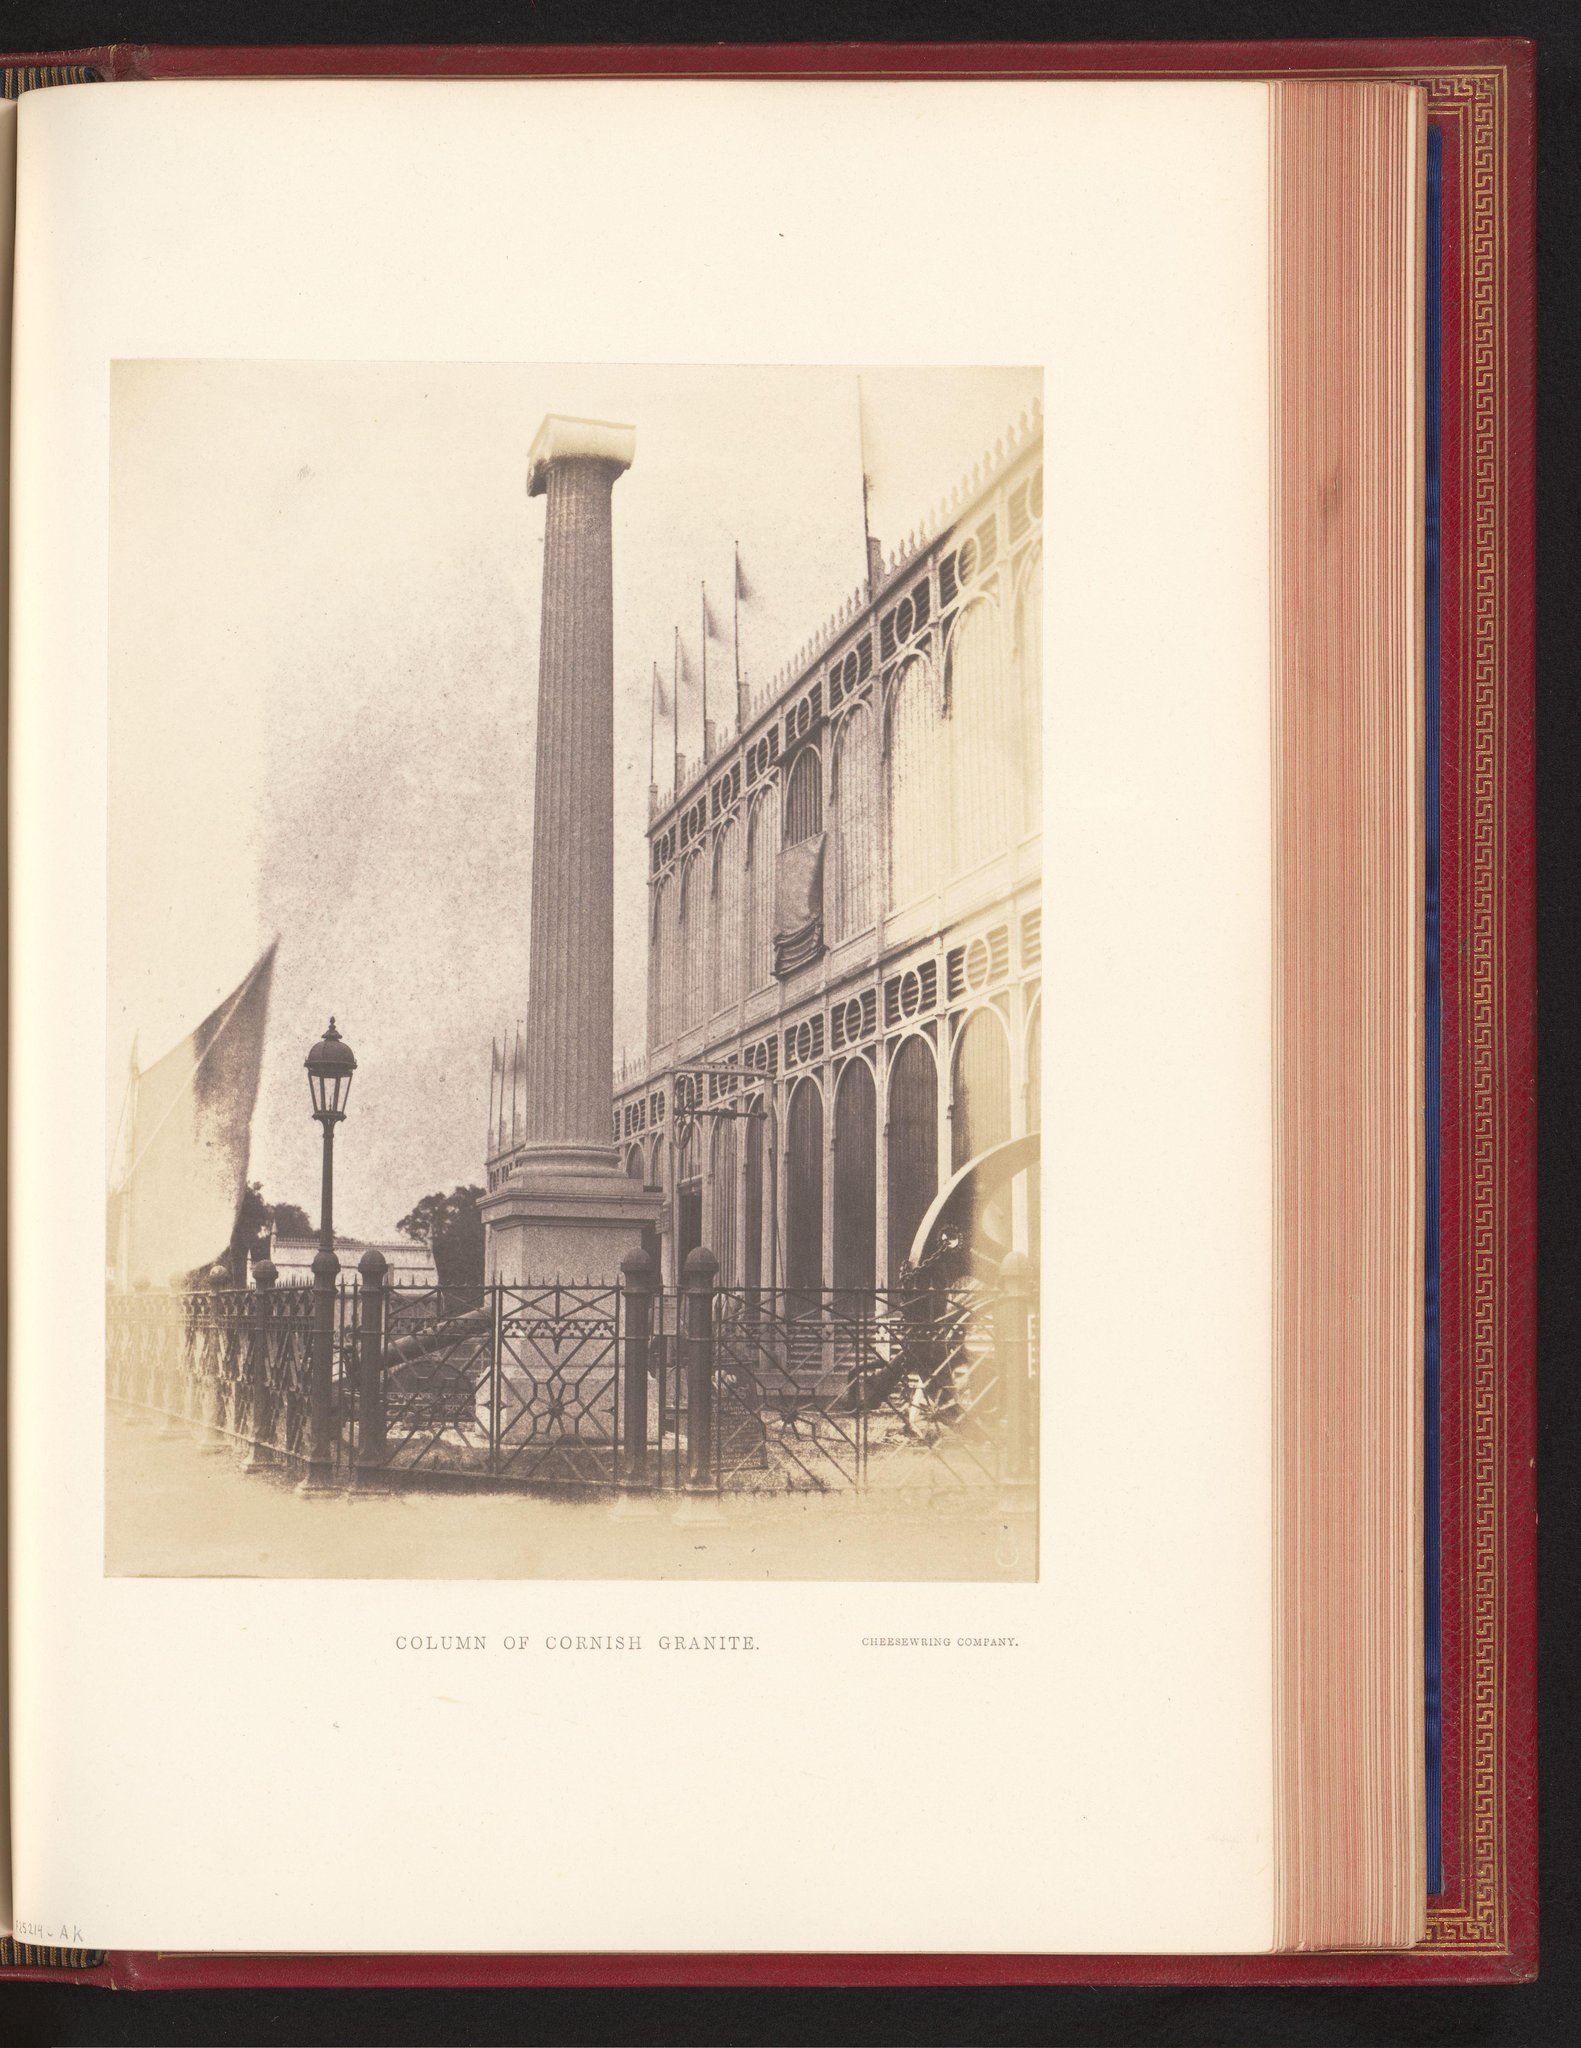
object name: photograph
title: Column of Cornish Granite. Cheesewring Company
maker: hugh owen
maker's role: fotograaf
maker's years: 1808-1897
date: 1851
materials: photographic support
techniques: salted paper print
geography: london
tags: column, pillar ~ architecture, london